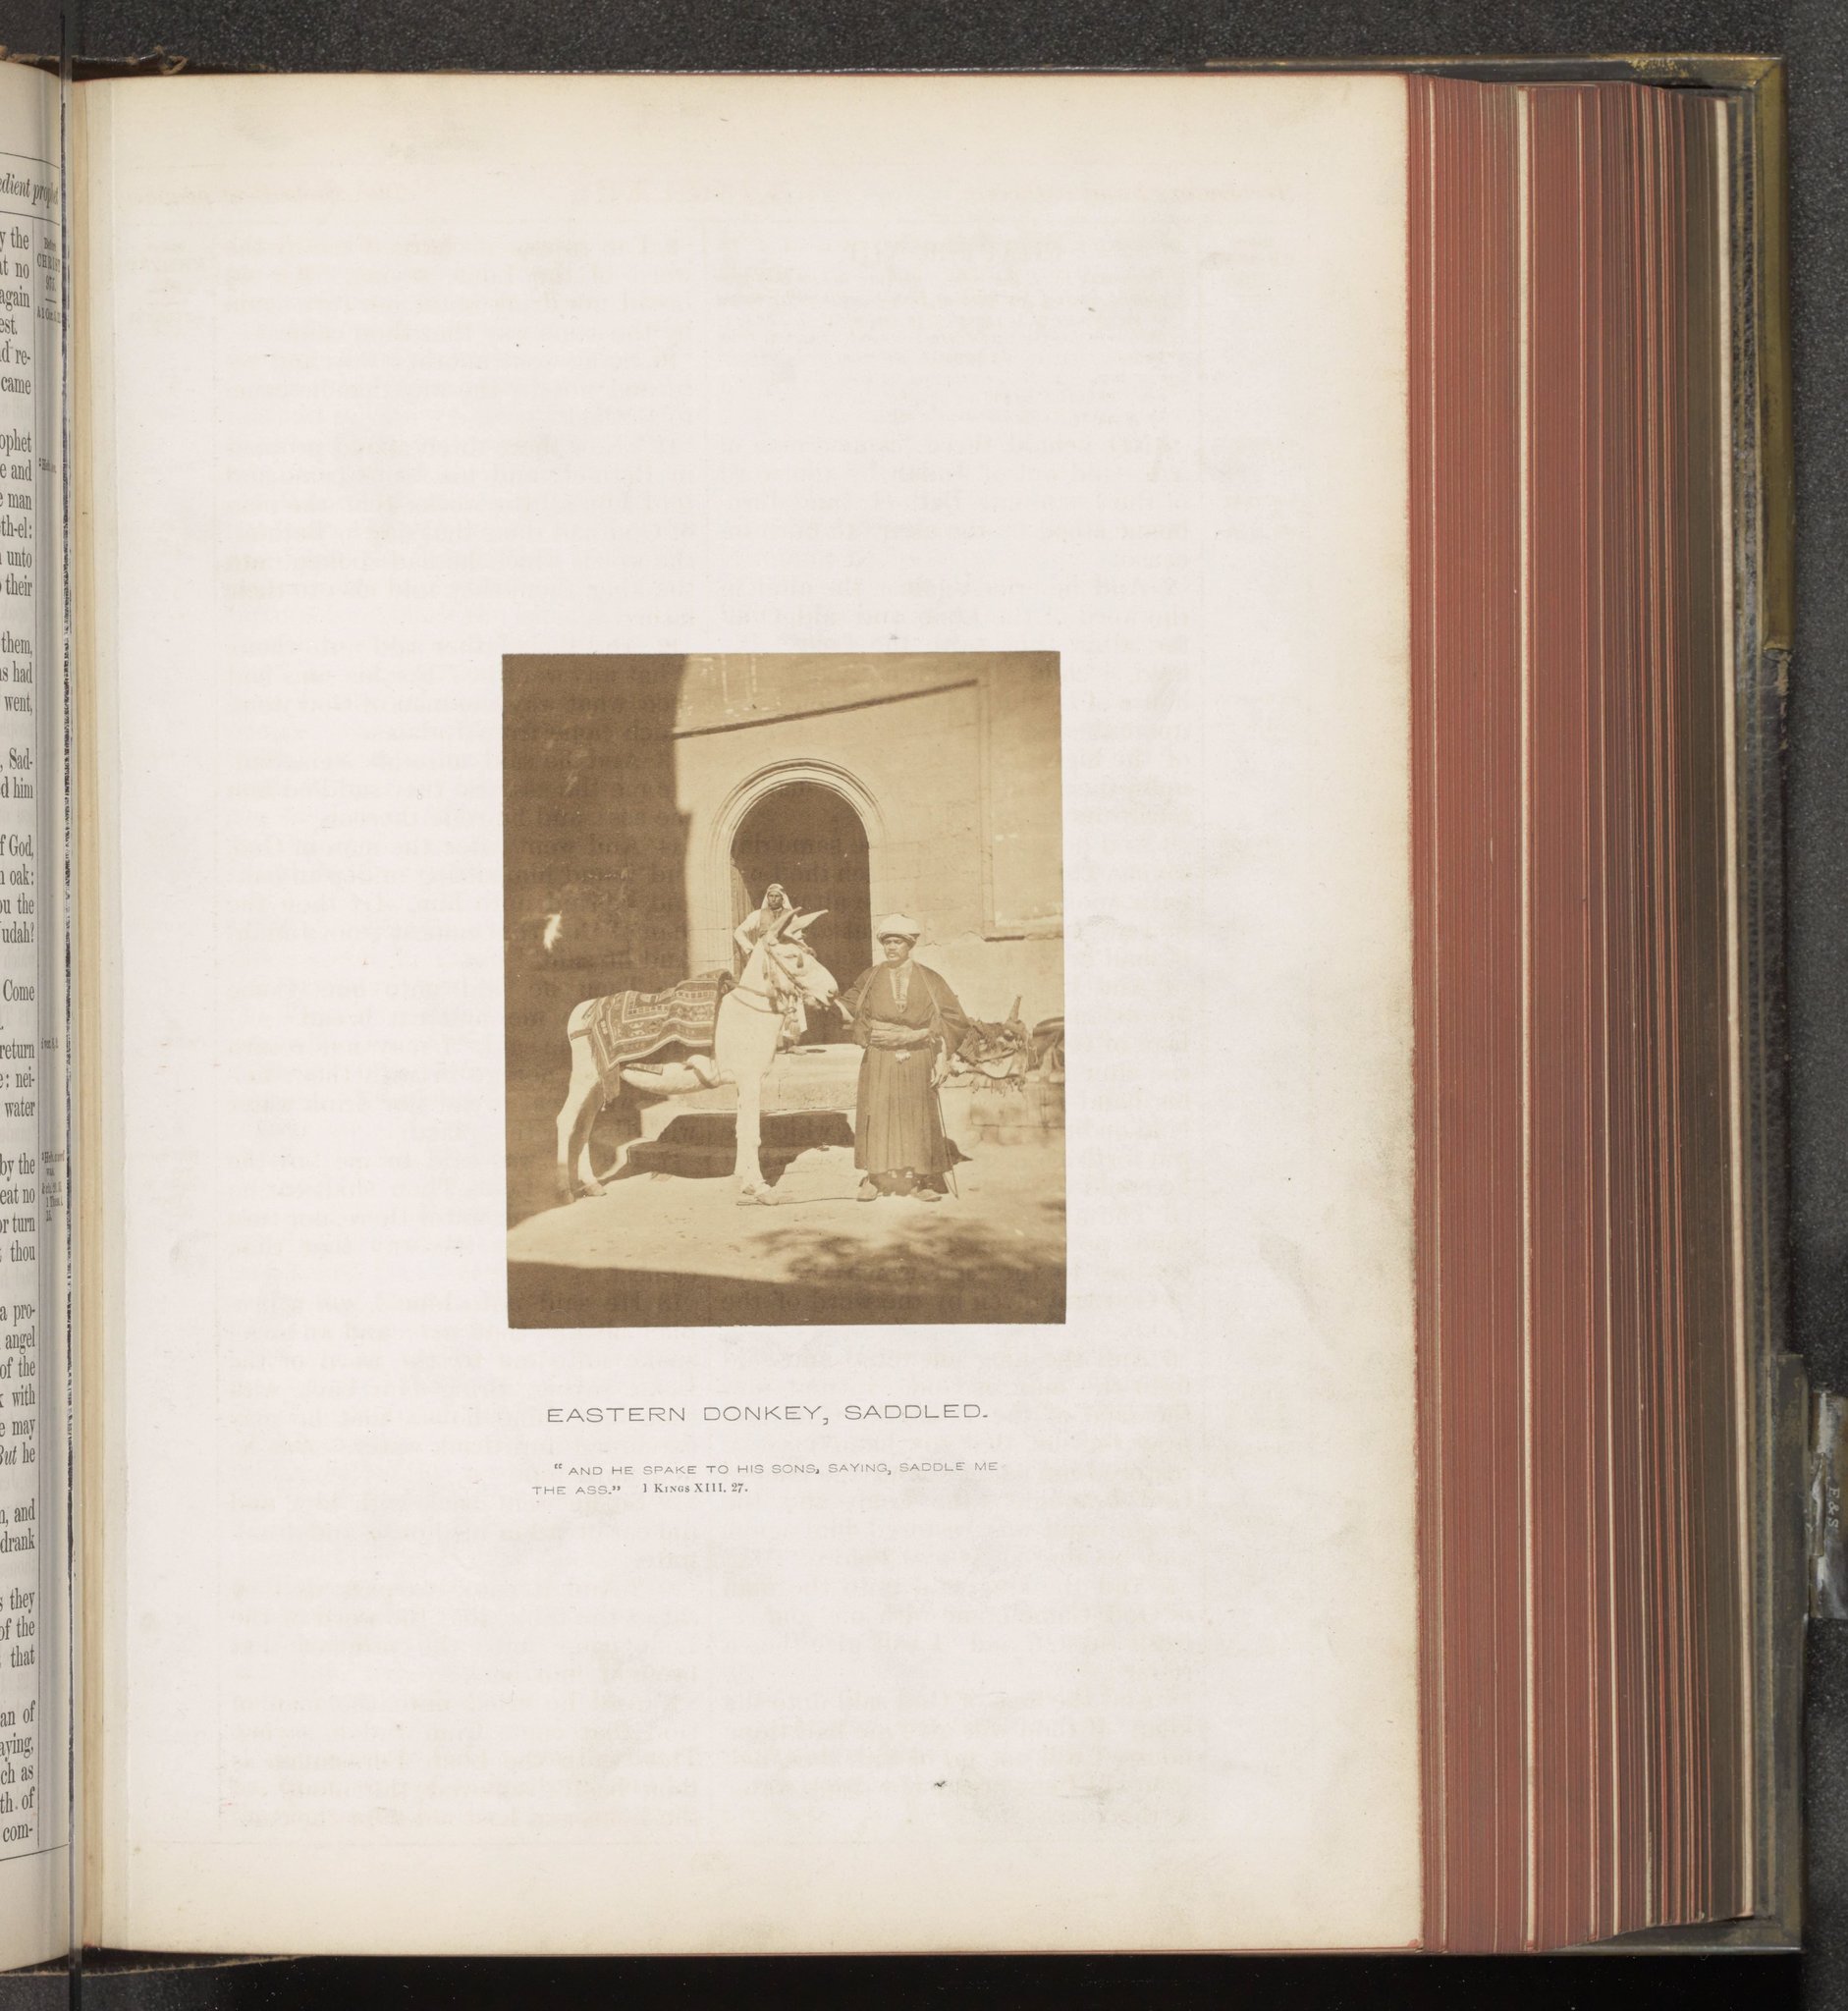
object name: page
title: Eastern donkey, saddled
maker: francis frith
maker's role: publisher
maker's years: 1822-1898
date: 1850-1865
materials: photographic support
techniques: albumen print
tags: ass, donkey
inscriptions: inscription: ‘"And he spake to his sons, saying, saddle me the ass."1 Kings XIII.27.’